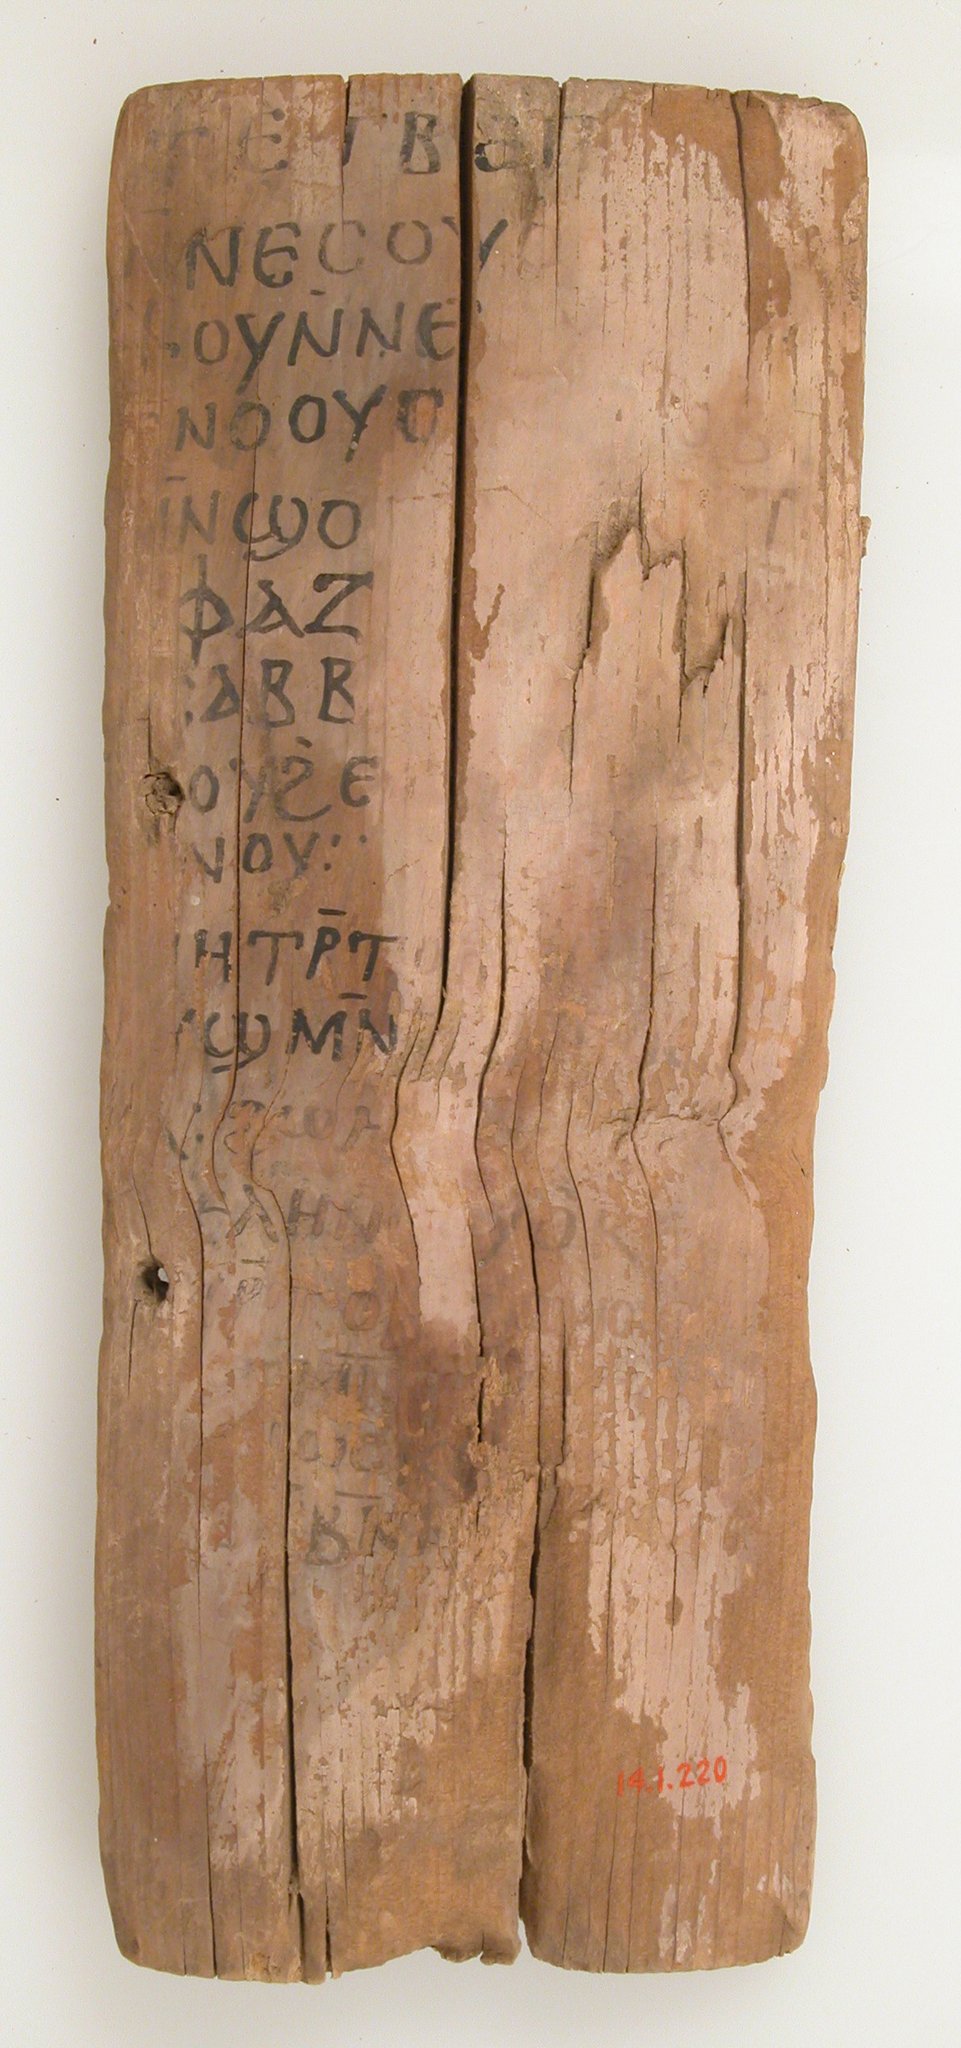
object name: ostrakon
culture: coptic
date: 580-640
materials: ink, wood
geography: egypt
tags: coptic,documents